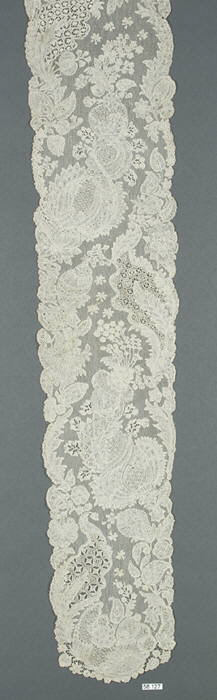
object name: lappet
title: Pair of joined lappets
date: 1701-1733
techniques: lace